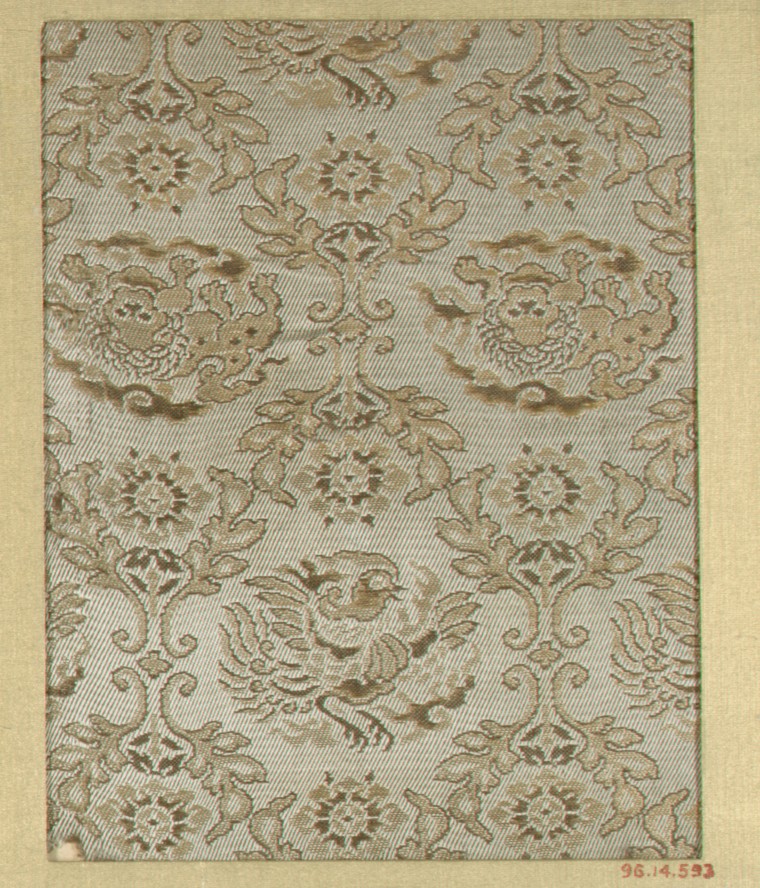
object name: piece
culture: japanese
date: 1701-1900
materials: silk